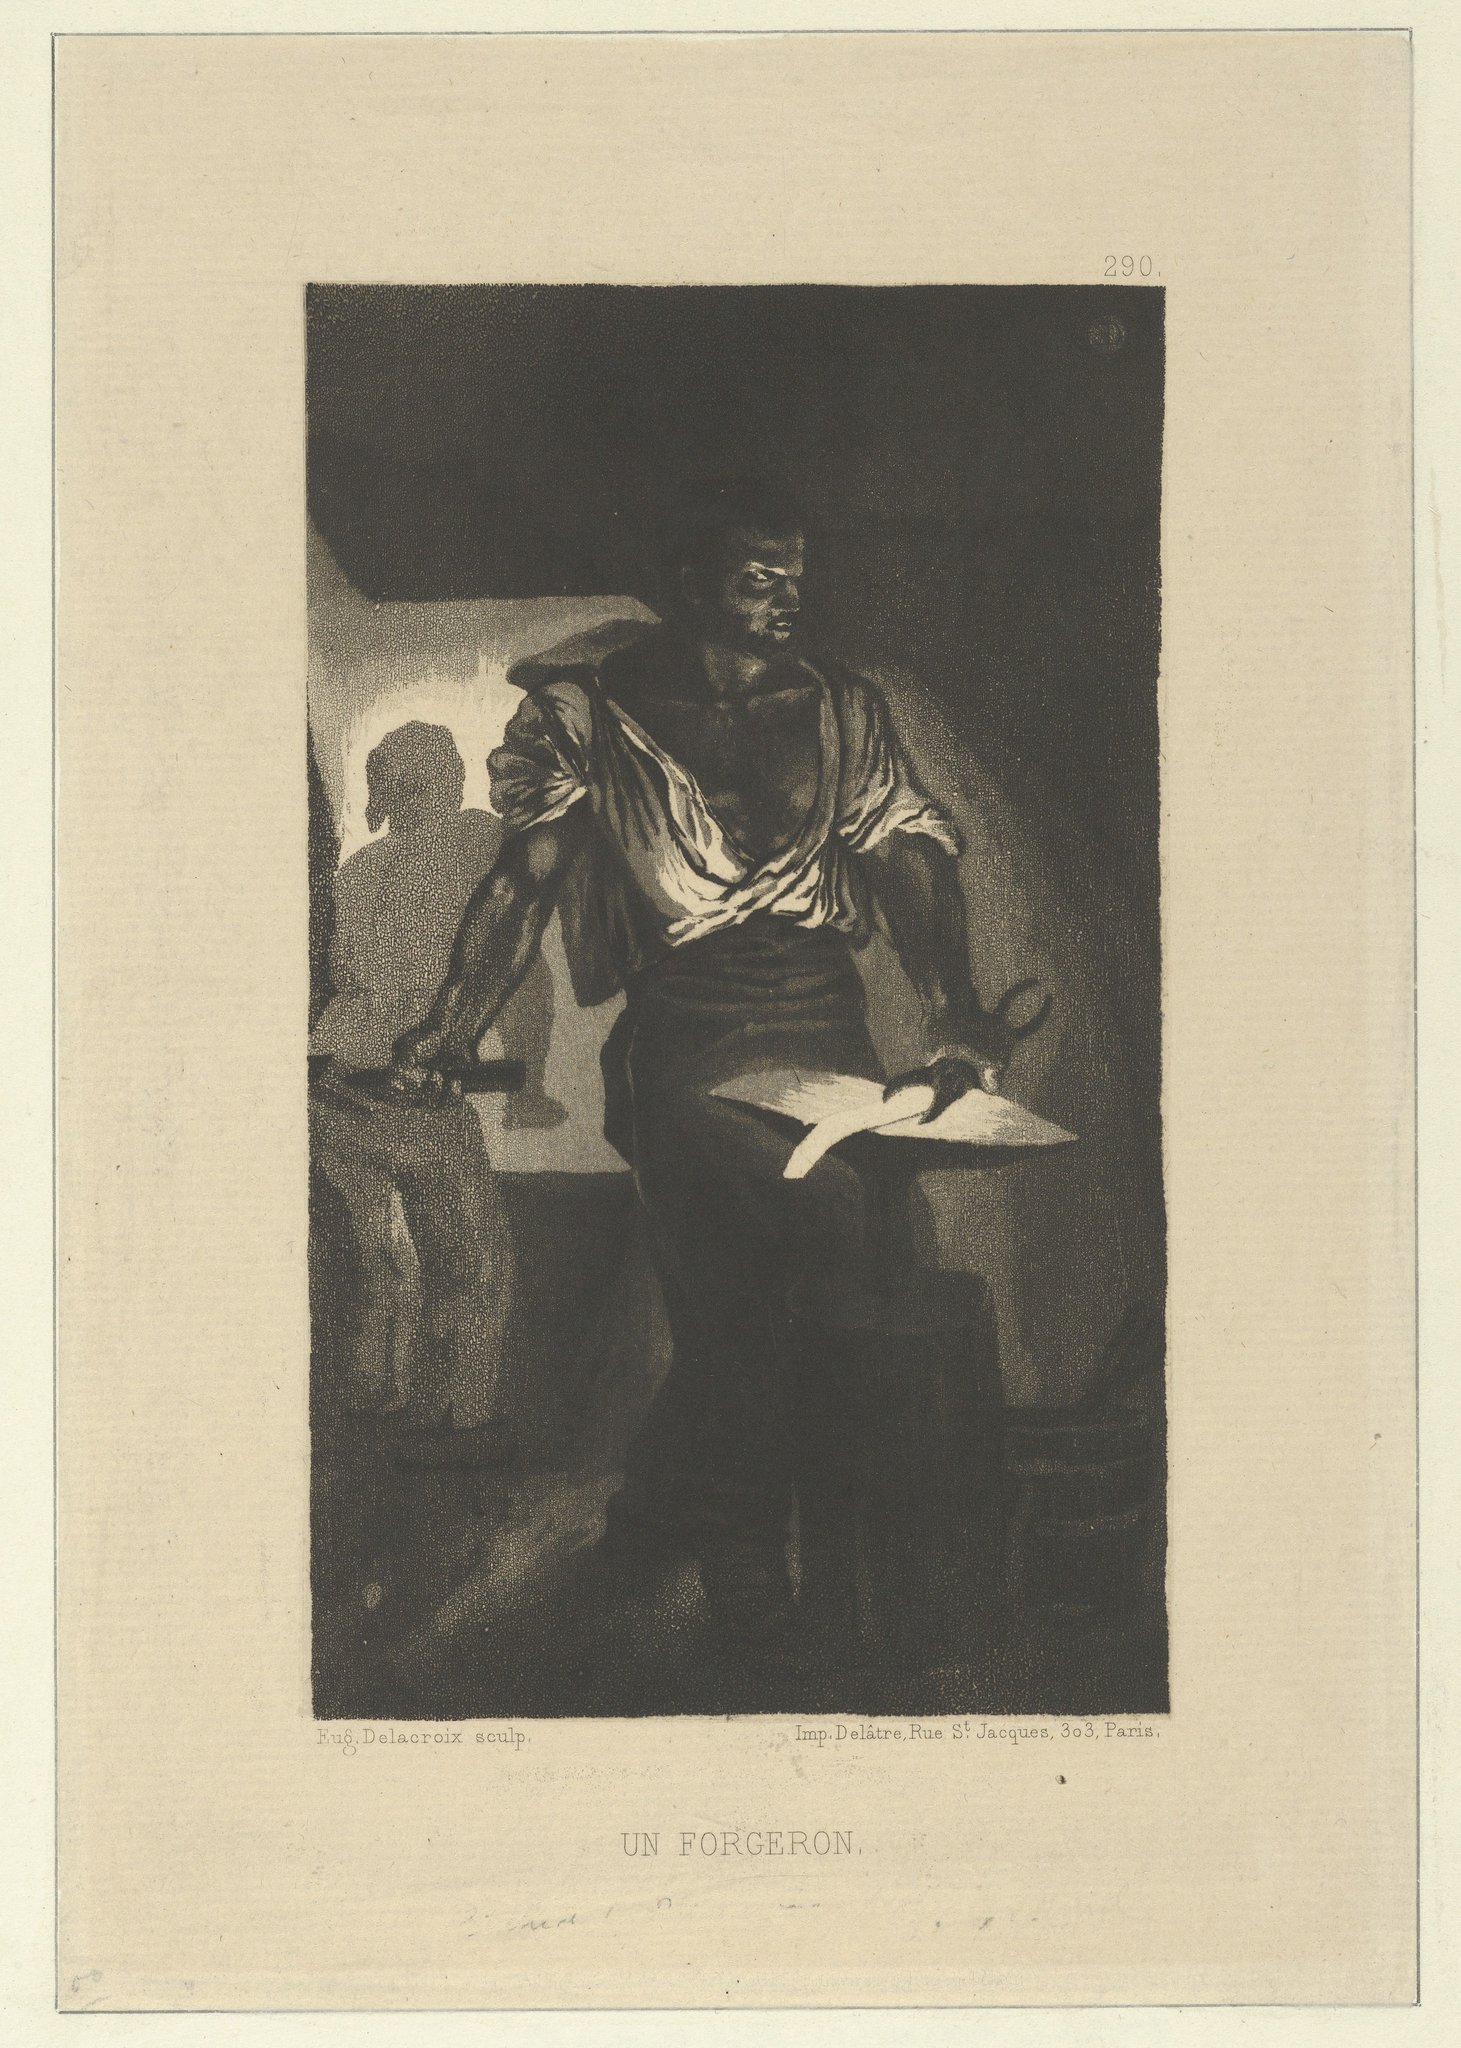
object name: print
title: A Blacksmith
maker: eugène delacroix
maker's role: artist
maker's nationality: french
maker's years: 1798-1863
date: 1833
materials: paper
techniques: aquatint, drypoint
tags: men,blacksmiths